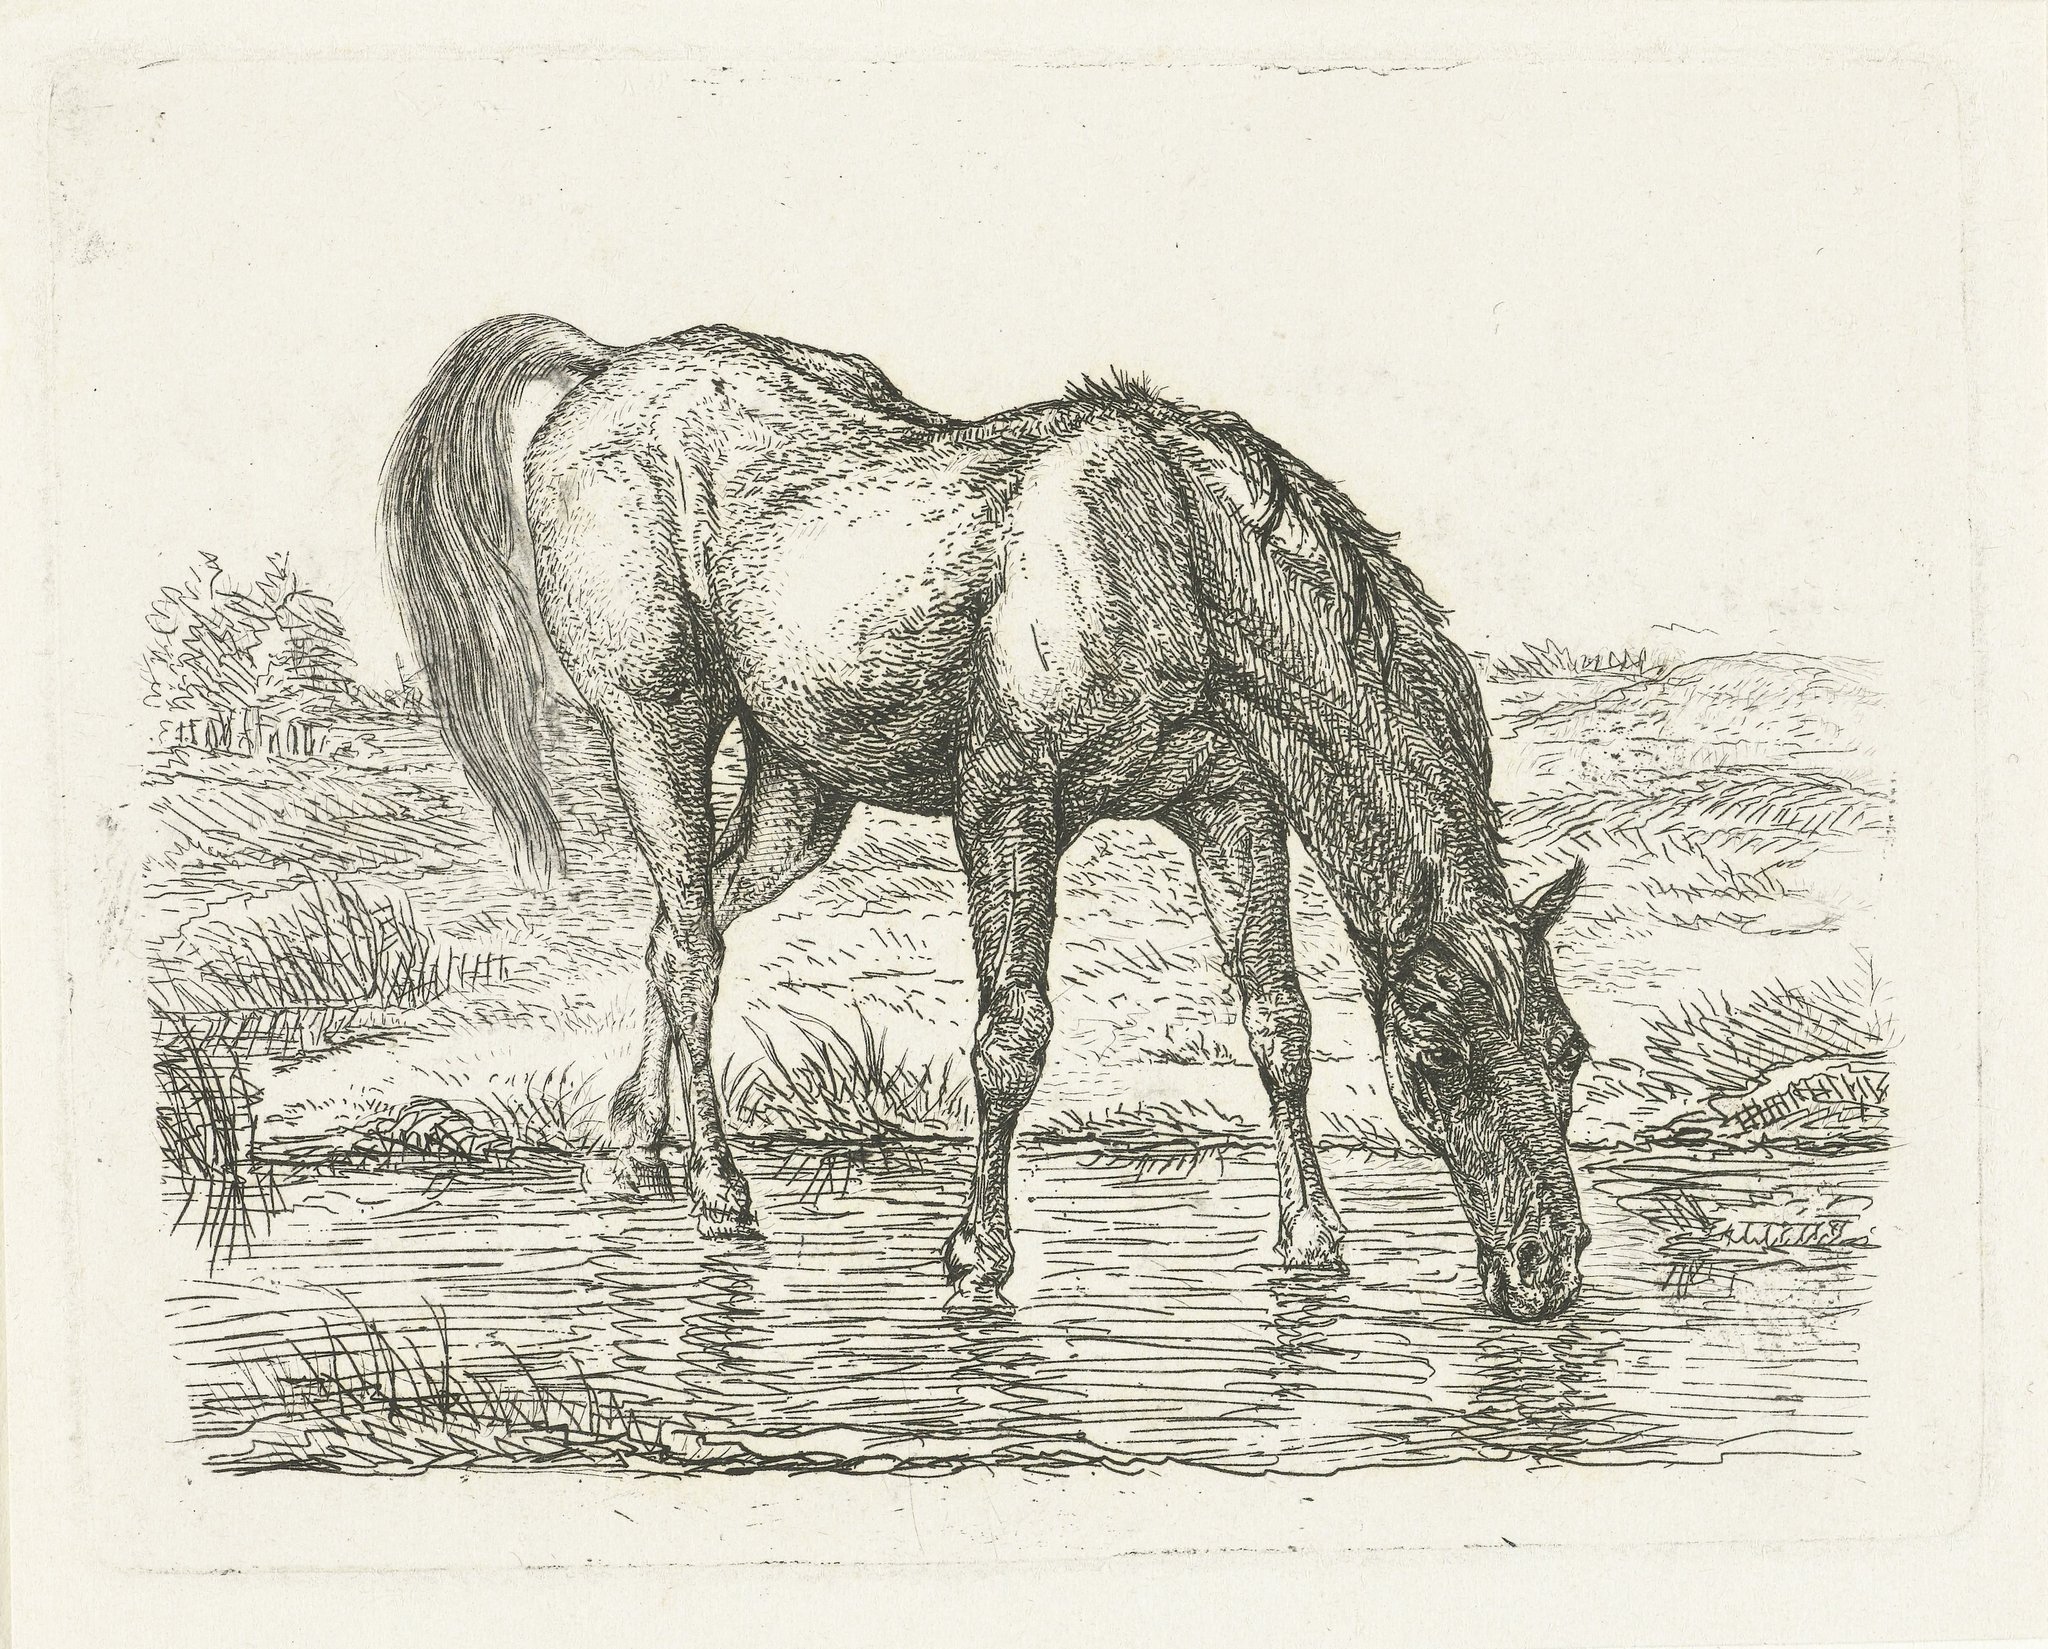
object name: print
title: Drinkend paard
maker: jan dasveldt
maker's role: draughtsman, print maker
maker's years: 1770-1855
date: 1780-1855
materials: paper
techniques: etching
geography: amsterdam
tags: horses and kindred animals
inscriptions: collector's mark: Lugt 2228